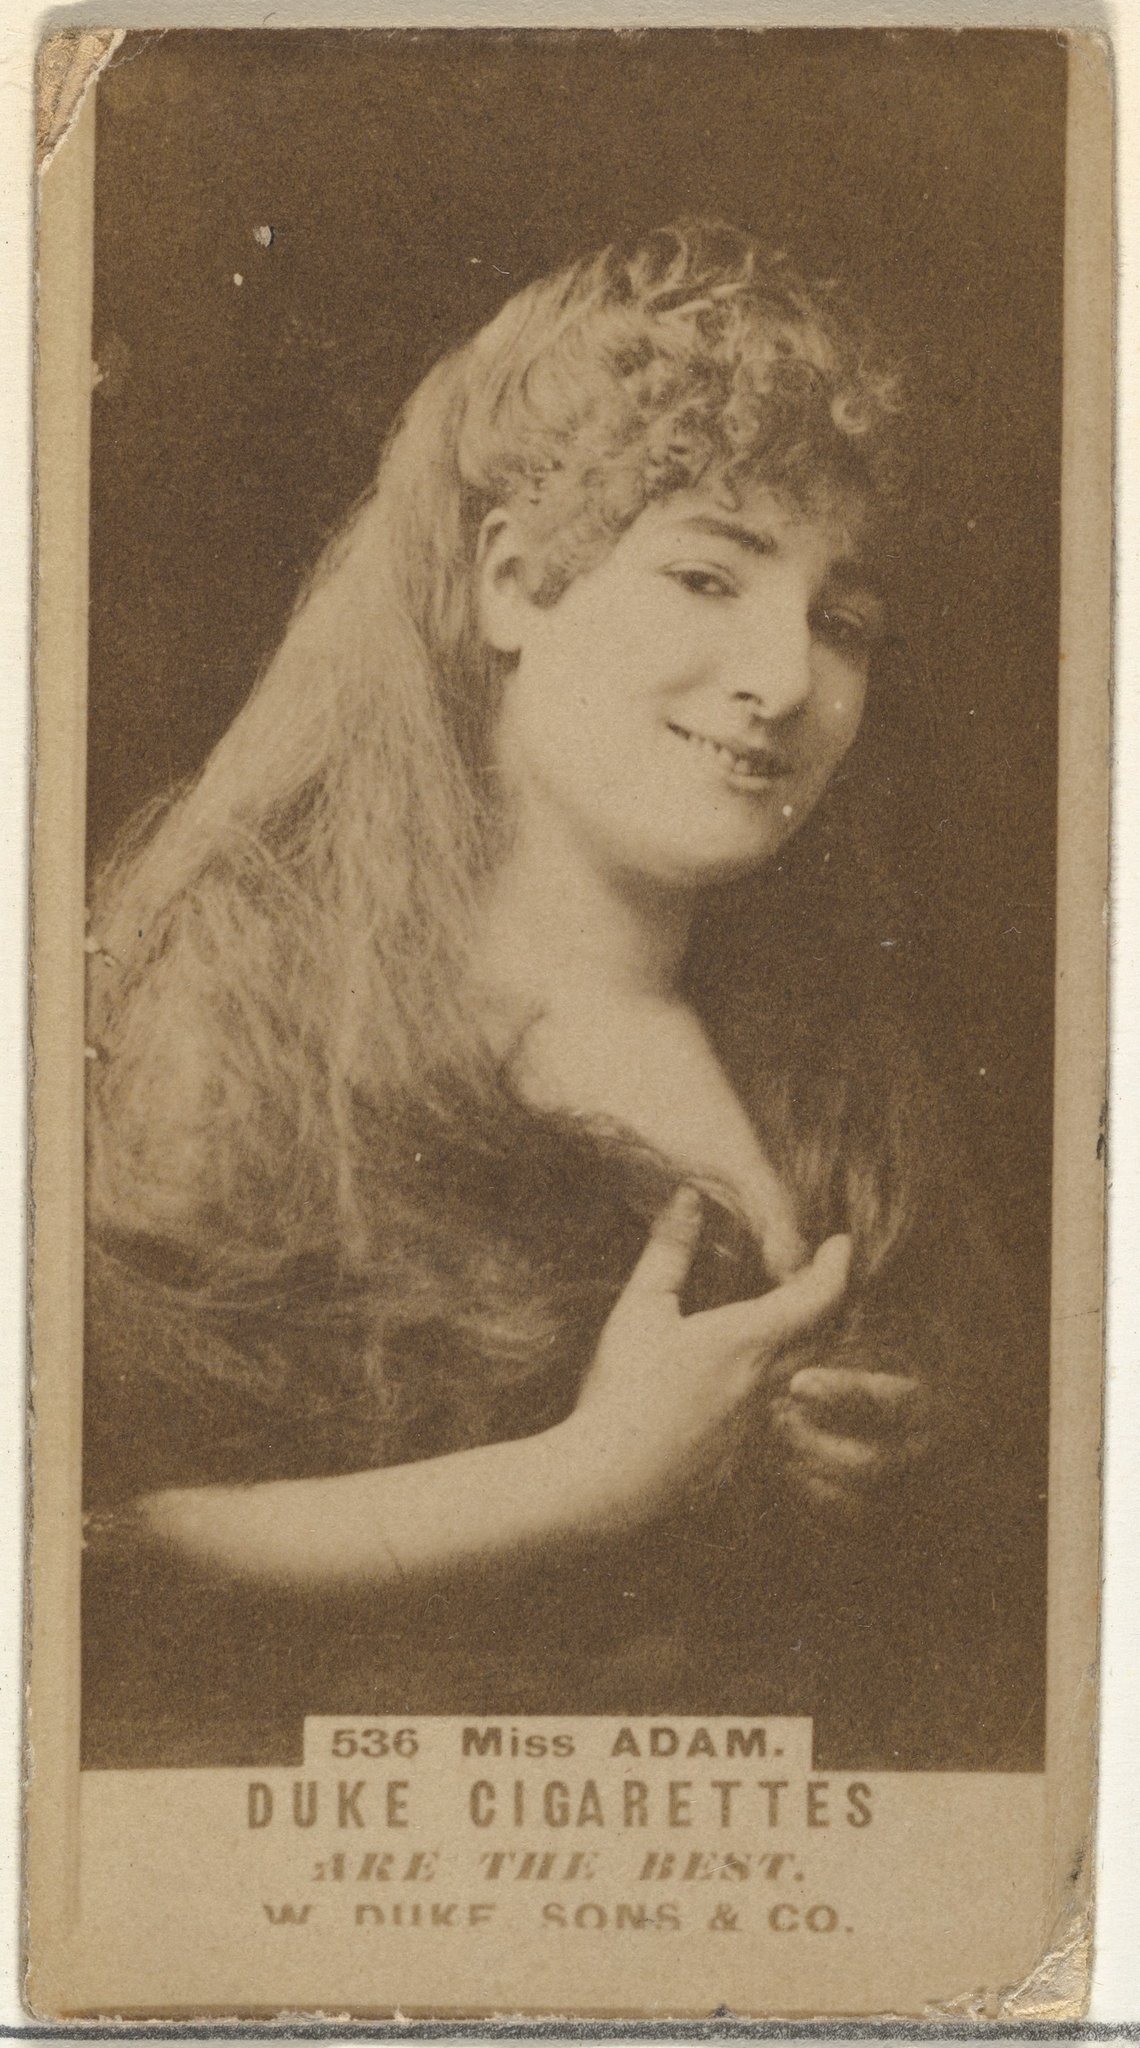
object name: photograph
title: Card Number 536, Miss Adam, from the Actors and Actresses series (N145-7) issued by Duke Sons & Co. to promote Duke Cigarettes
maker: w. duke, sons & co.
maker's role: publisher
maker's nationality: american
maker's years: 1870-1920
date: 1880-1889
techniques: albumen silver print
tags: portraits,women,actresses